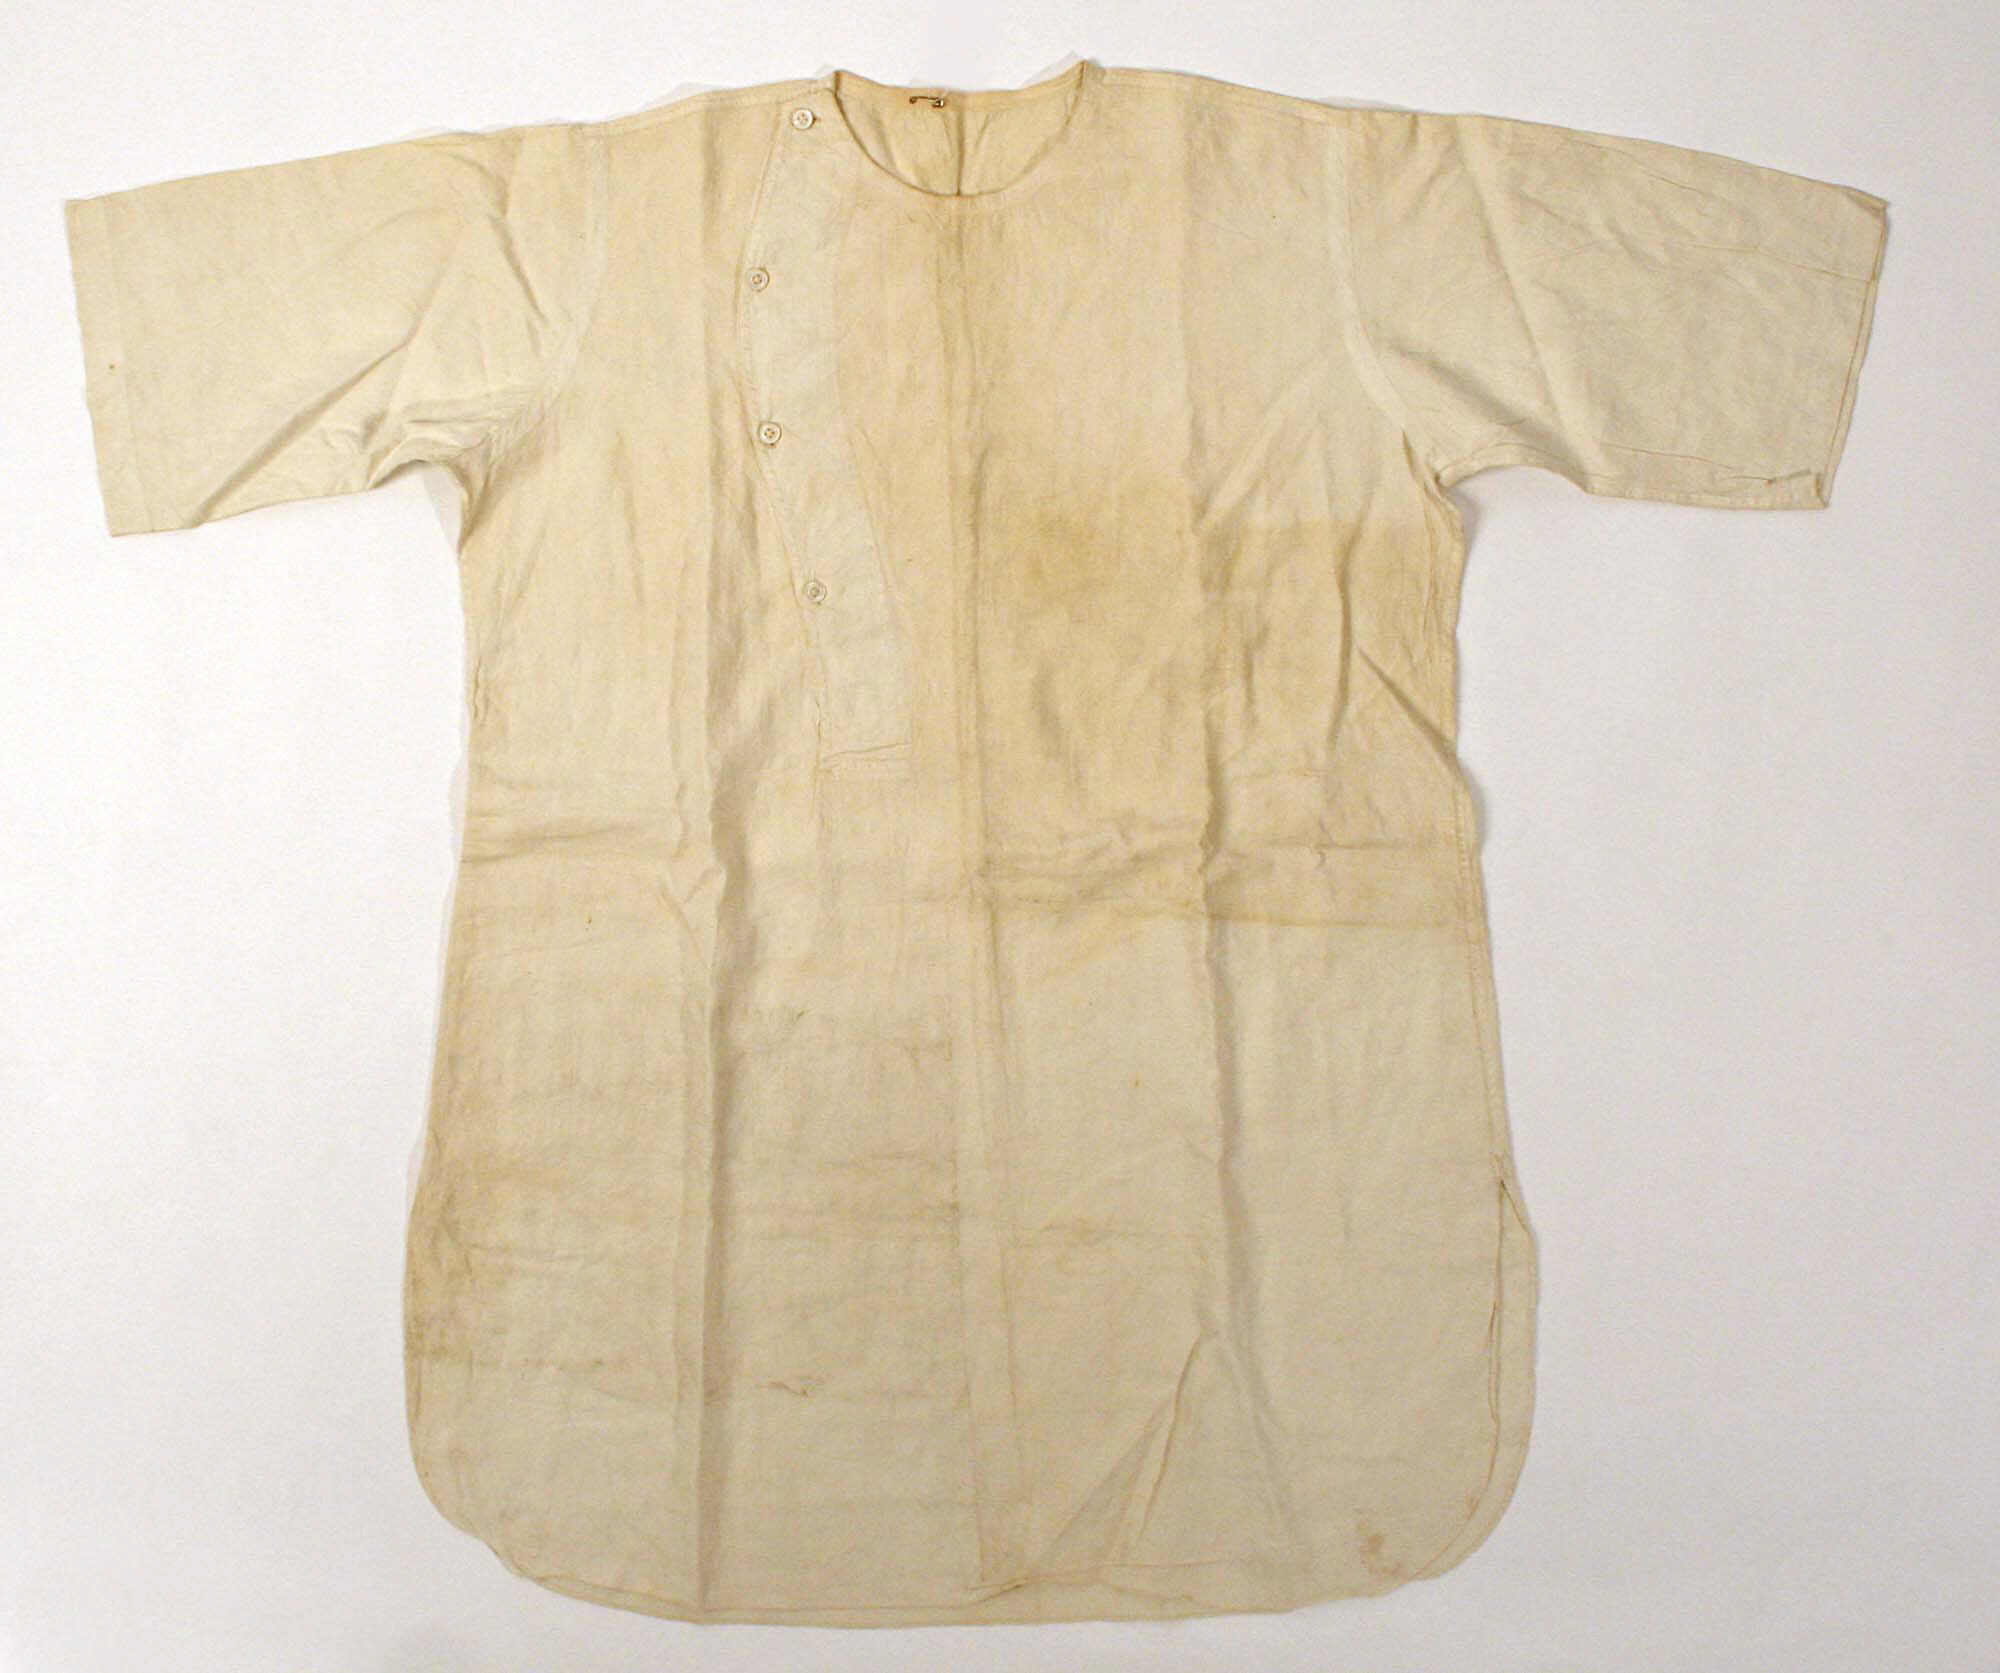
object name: pajama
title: Pajamas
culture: american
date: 1890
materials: linen